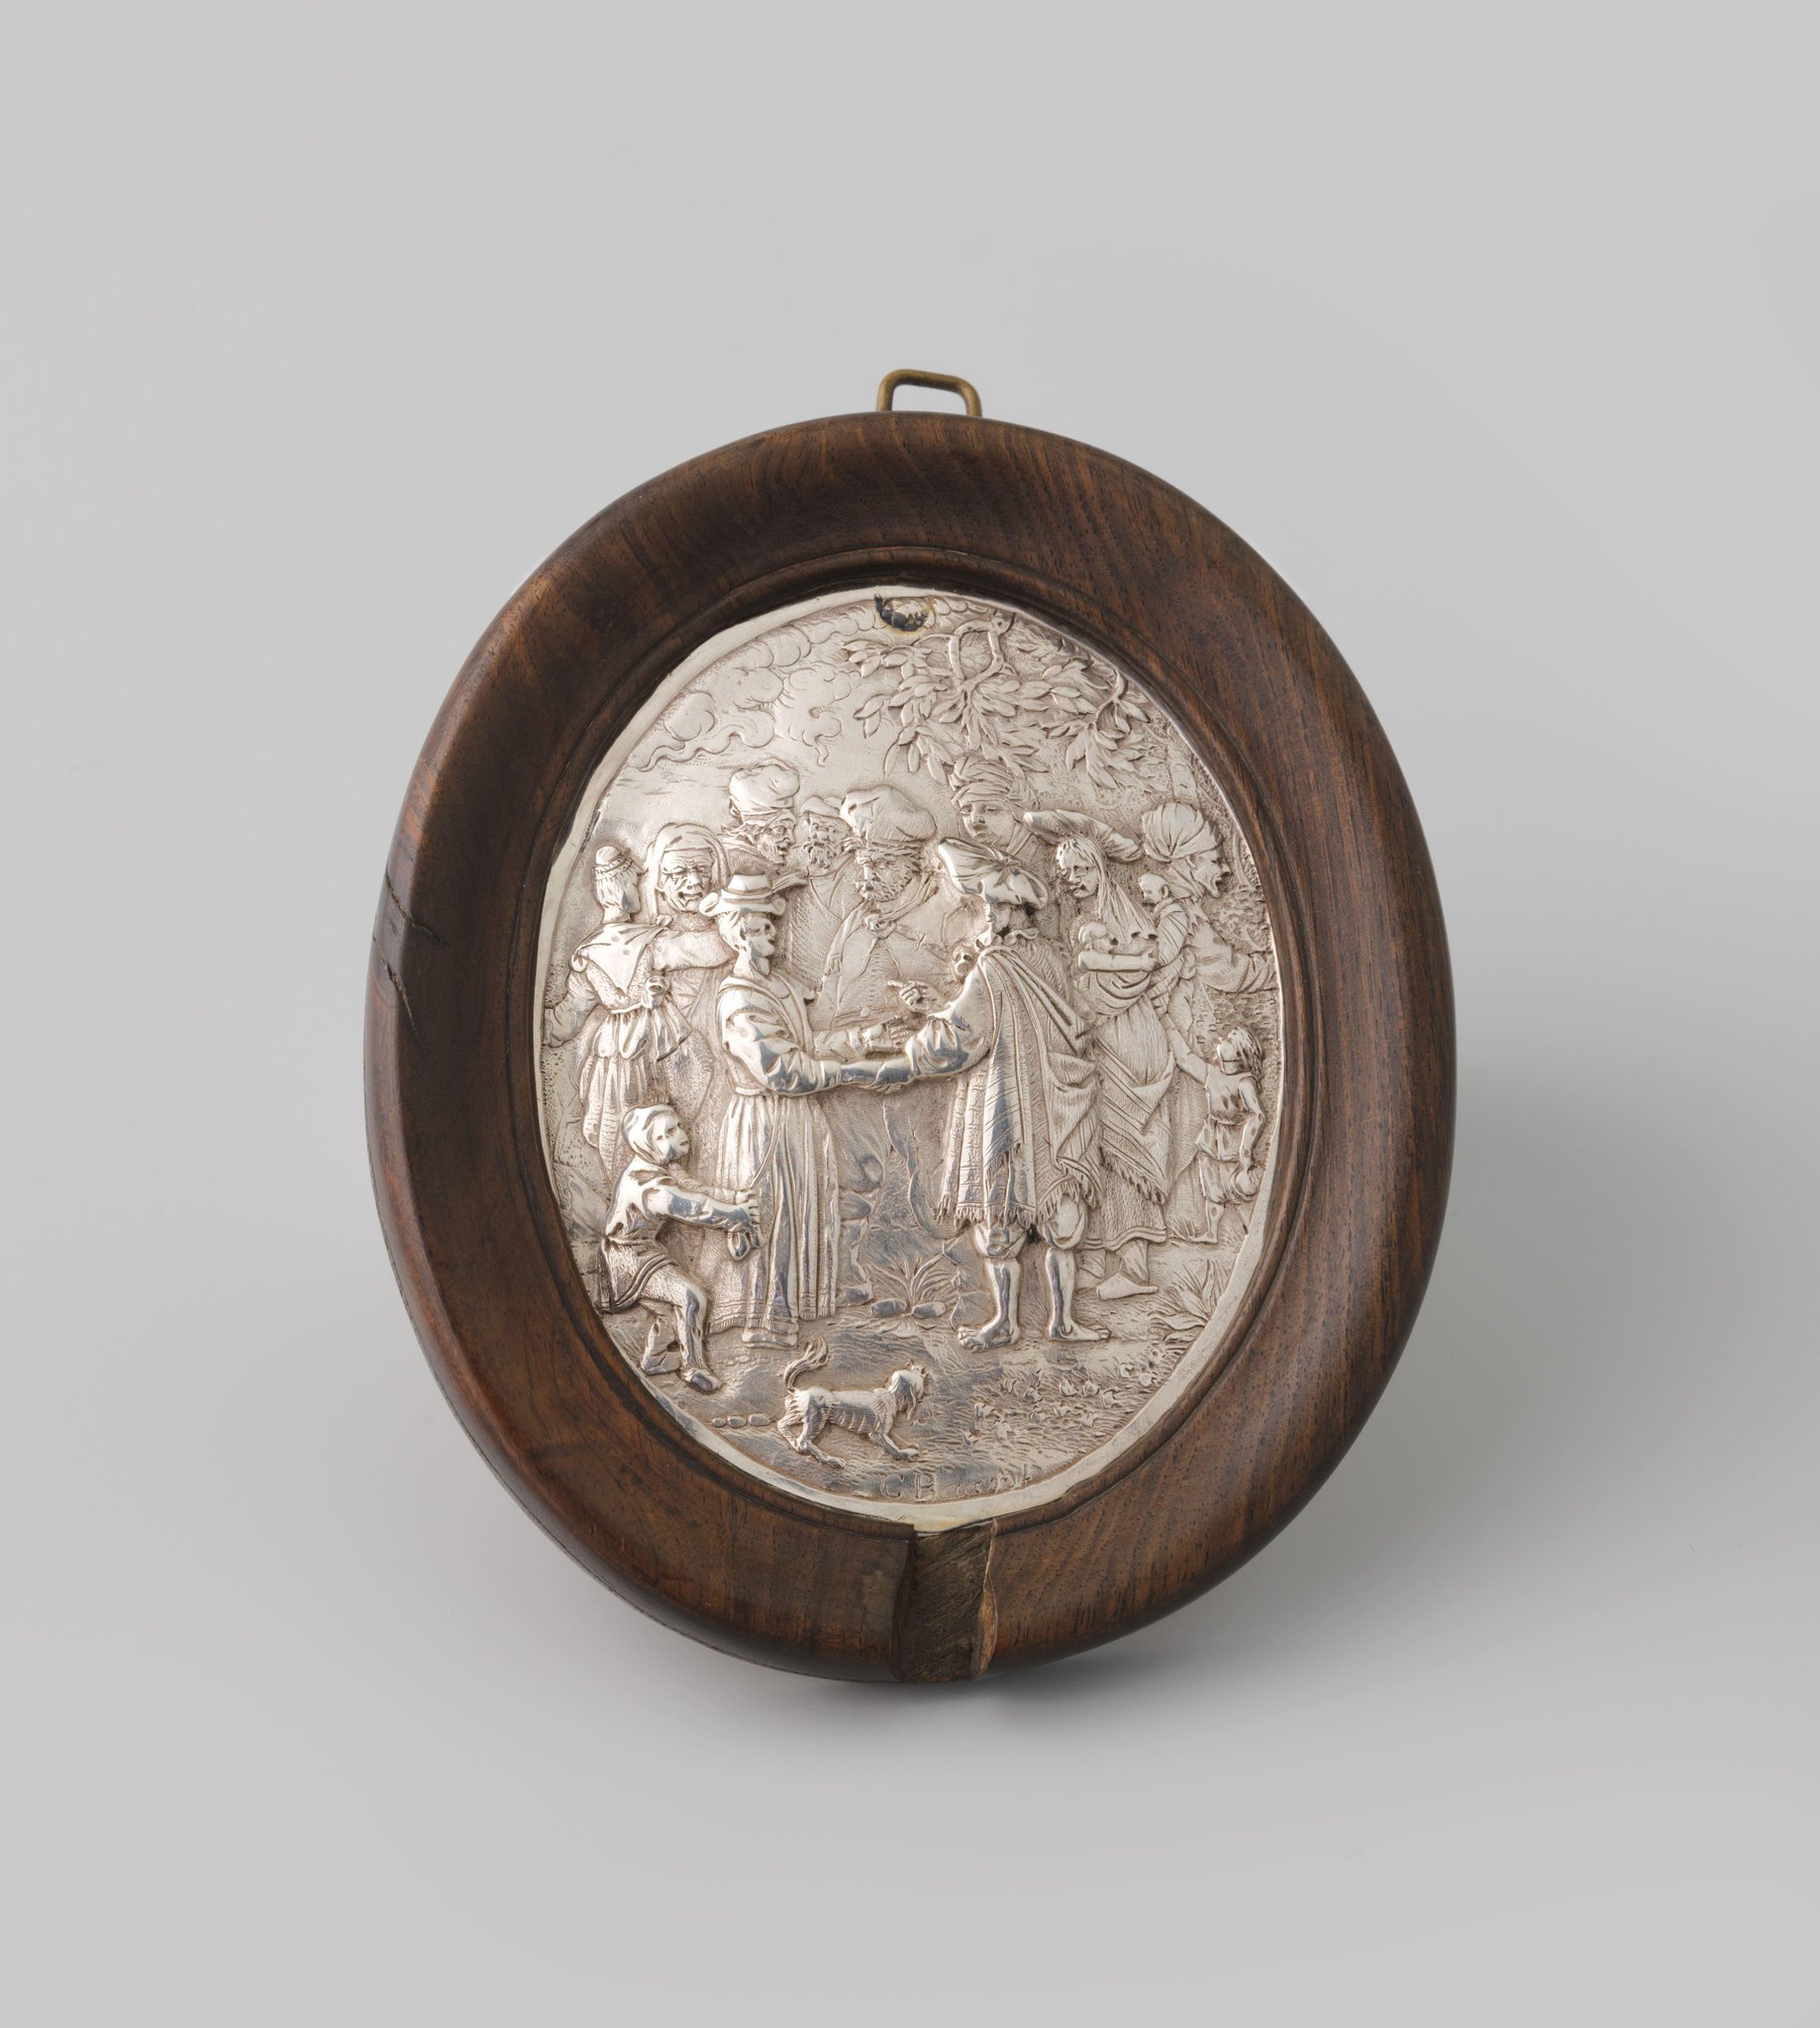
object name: plaque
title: Waarzeggersscène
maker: claes baardt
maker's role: silversmith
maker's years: 1628-1691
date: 1650-1700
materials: silver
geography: bolsward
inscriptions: signature: ‘C. Baardt’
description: Plaquette, silver. Bolsward, 2nd half of the 17th century, by Claes Baardt. Given by Mr A.A. van der Heyden.